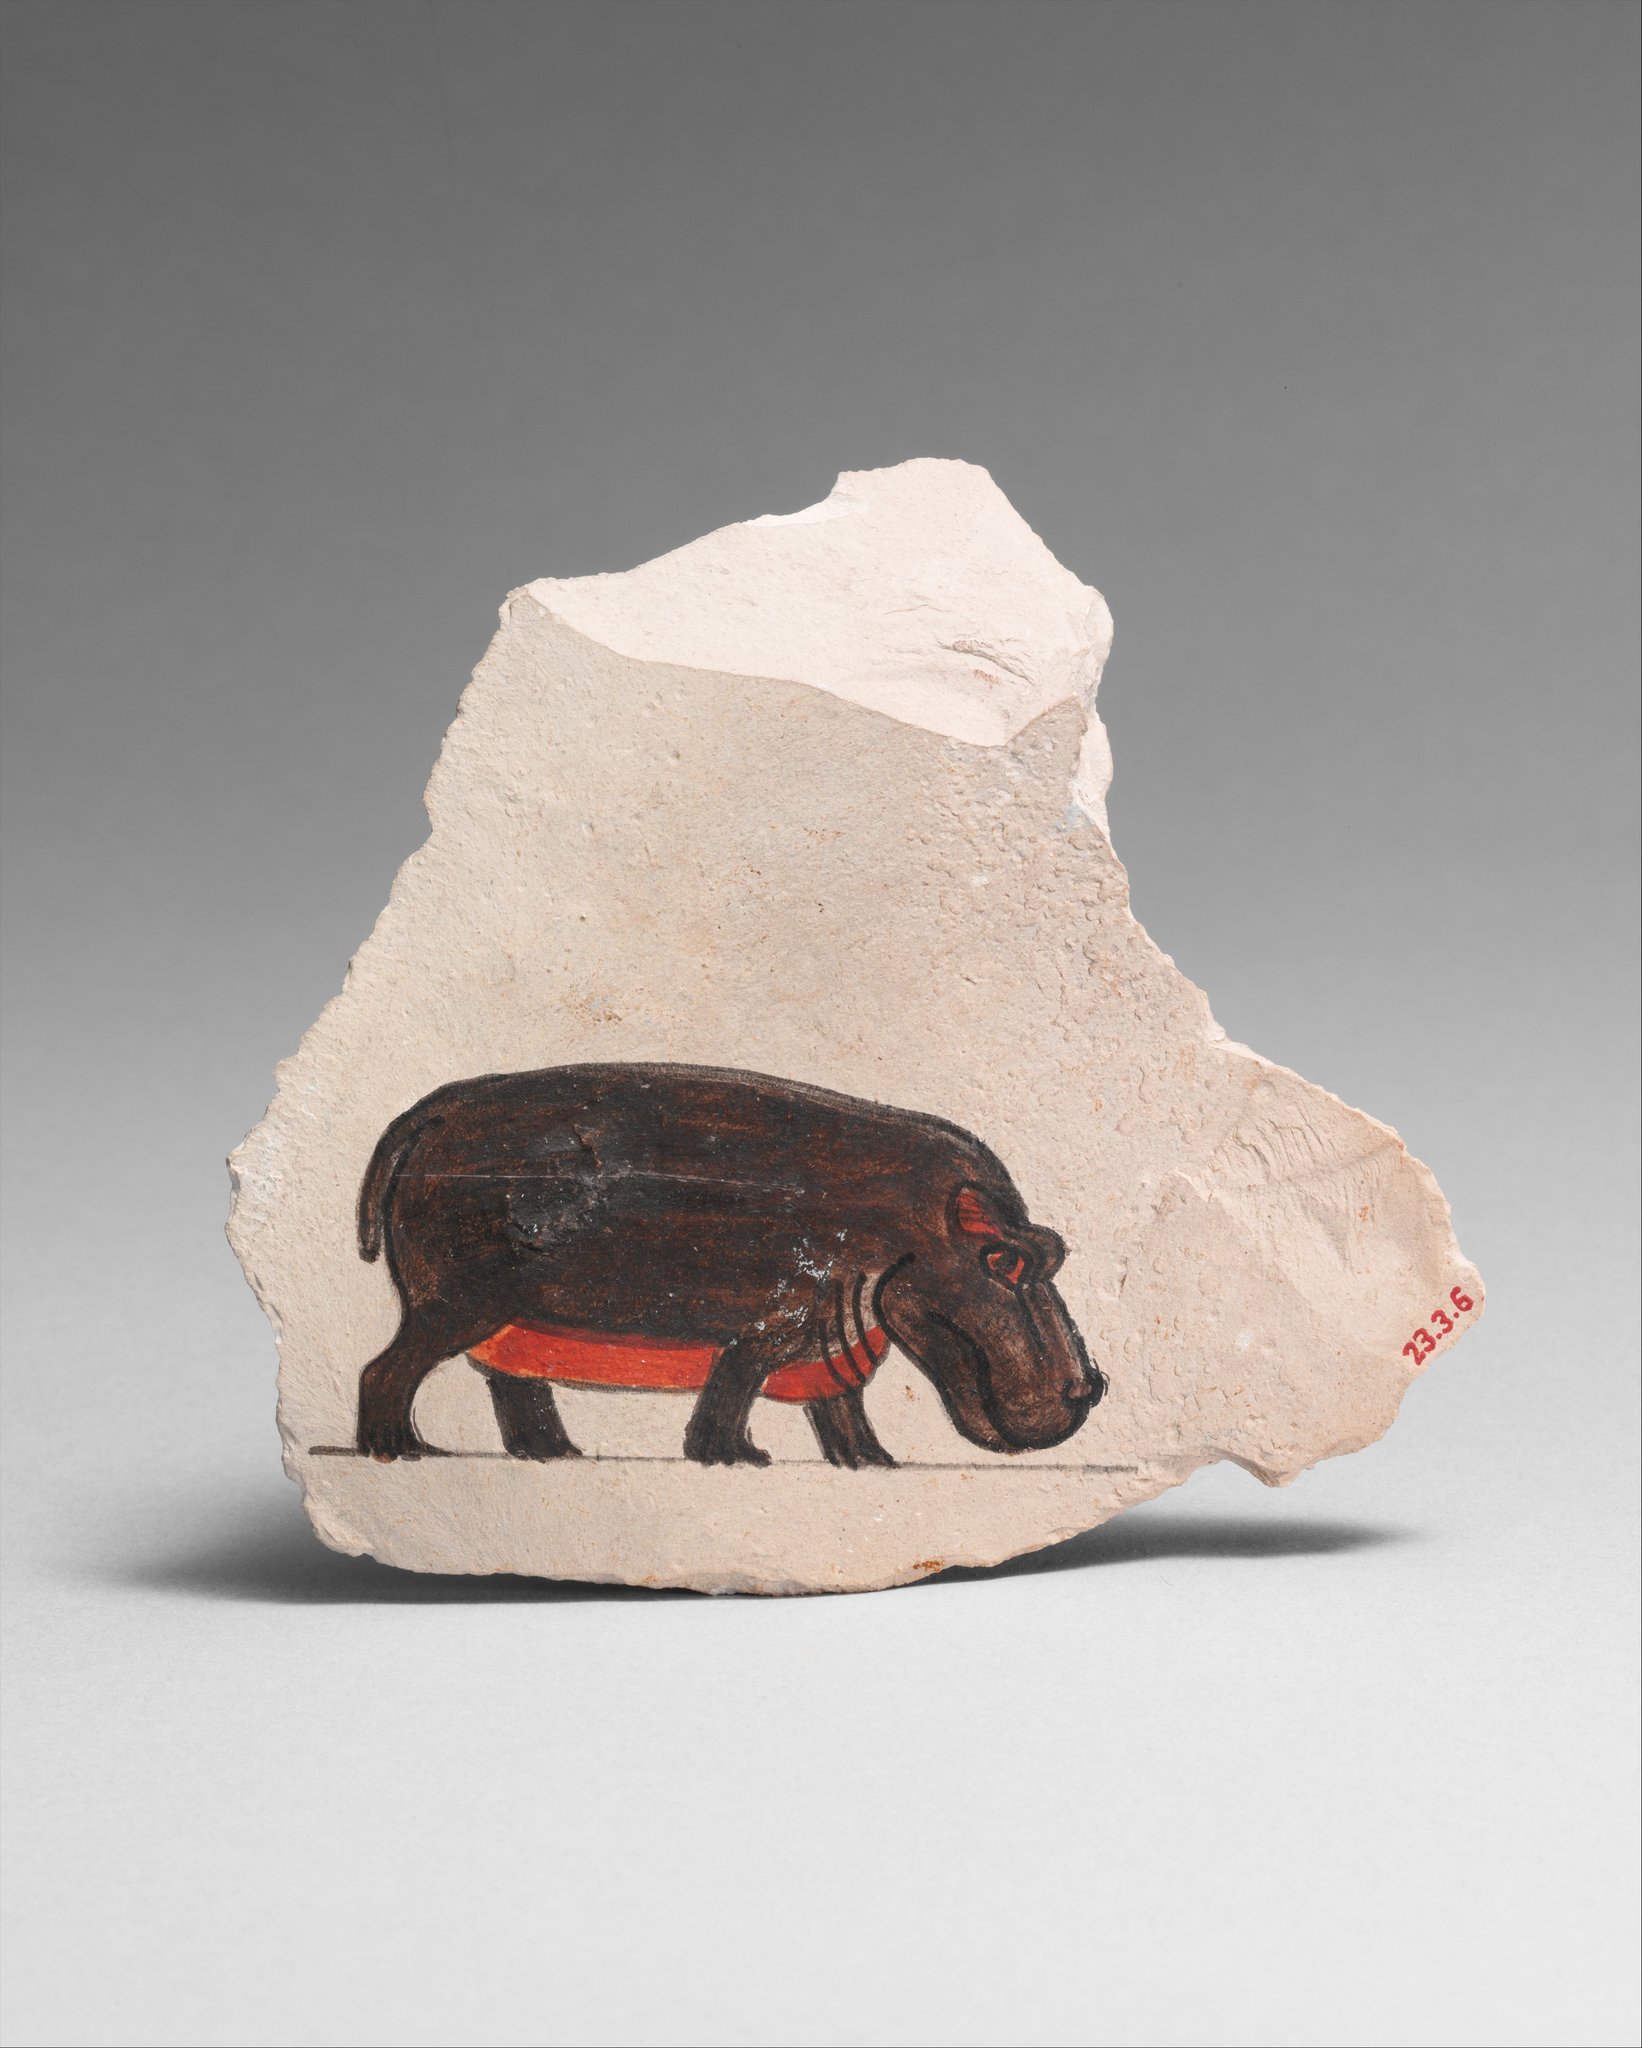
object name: ostracon, figured, hippopotamus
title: Artist's Painting of a Hippopotamus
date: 1479-1425 BCE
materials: limestone, paint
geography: egypt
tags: hippos